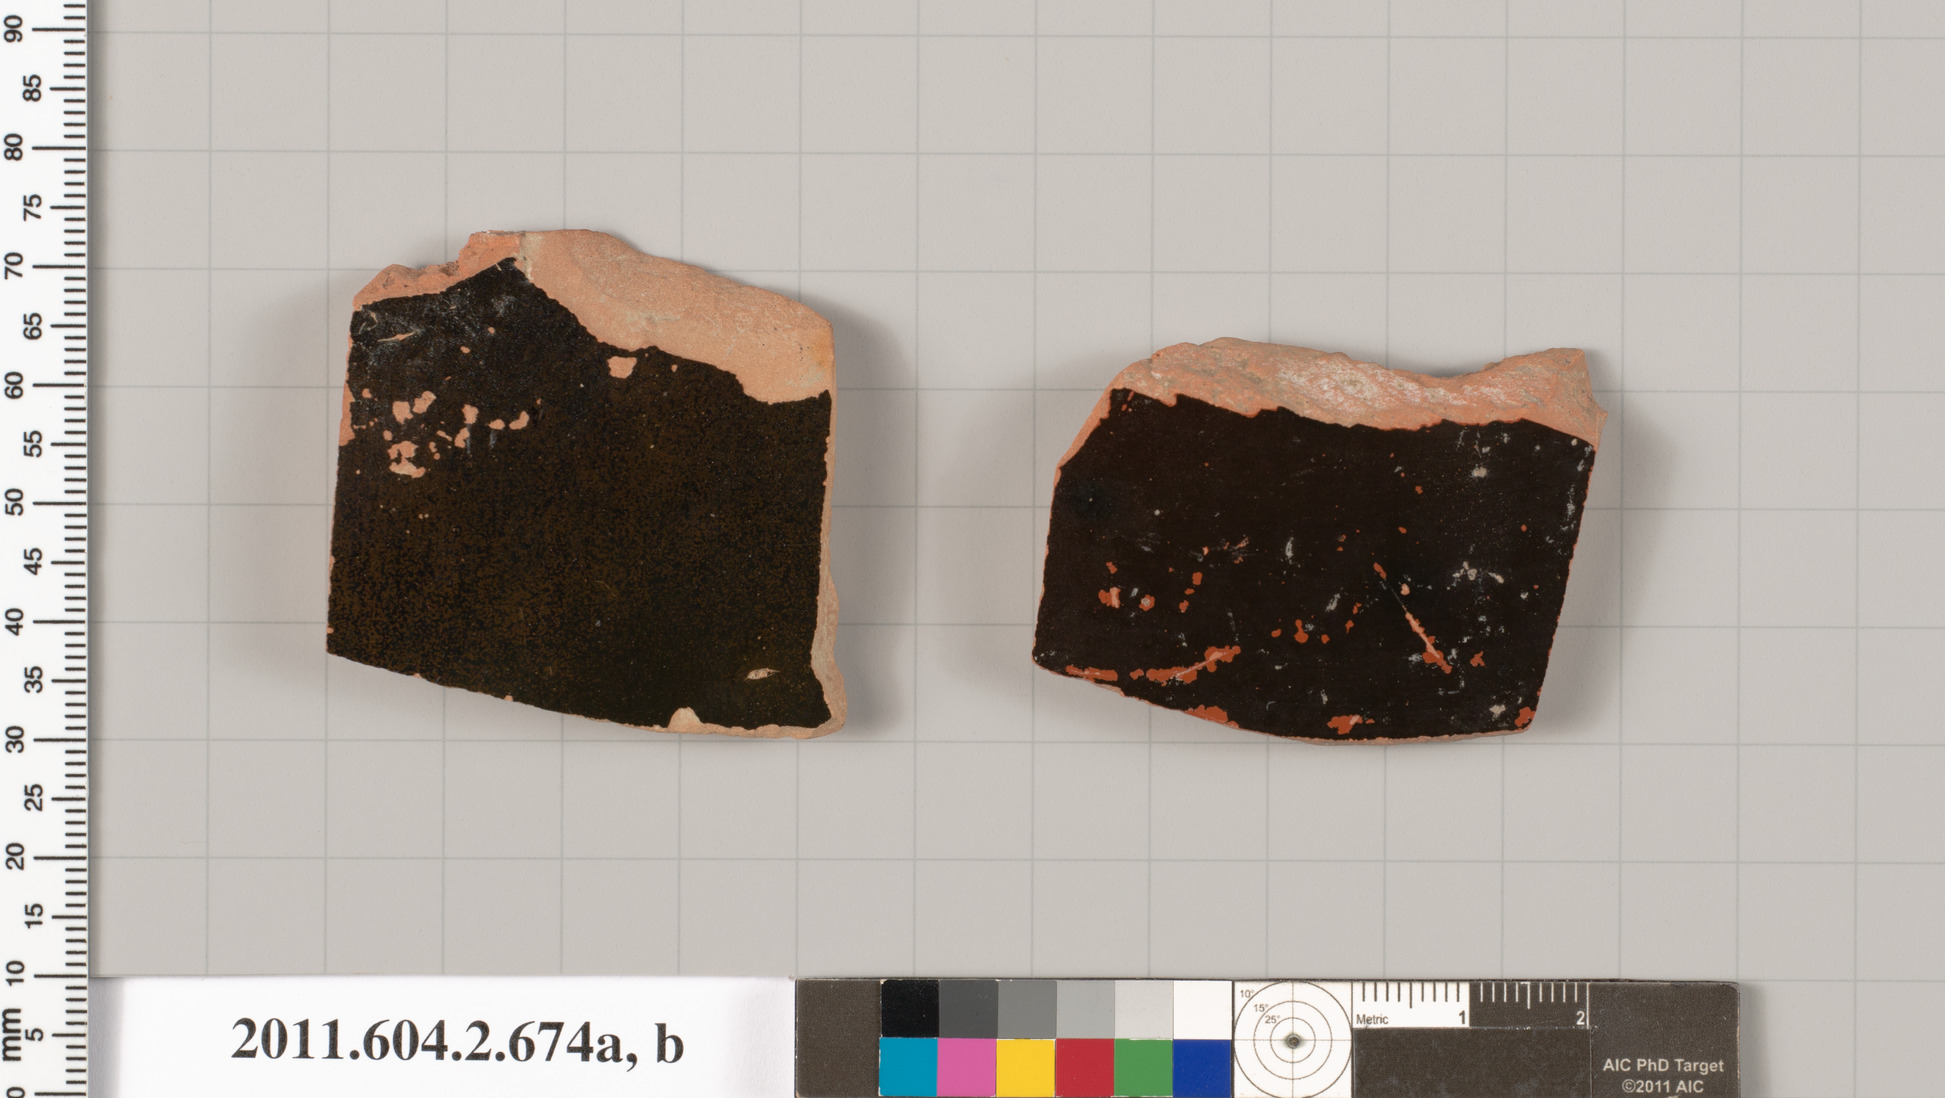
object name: column krater fragment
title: Terracotta fragments of column-kraters (bowls for mixing wine and water)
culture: greek, attic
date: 475-440 BCE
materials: terracotta